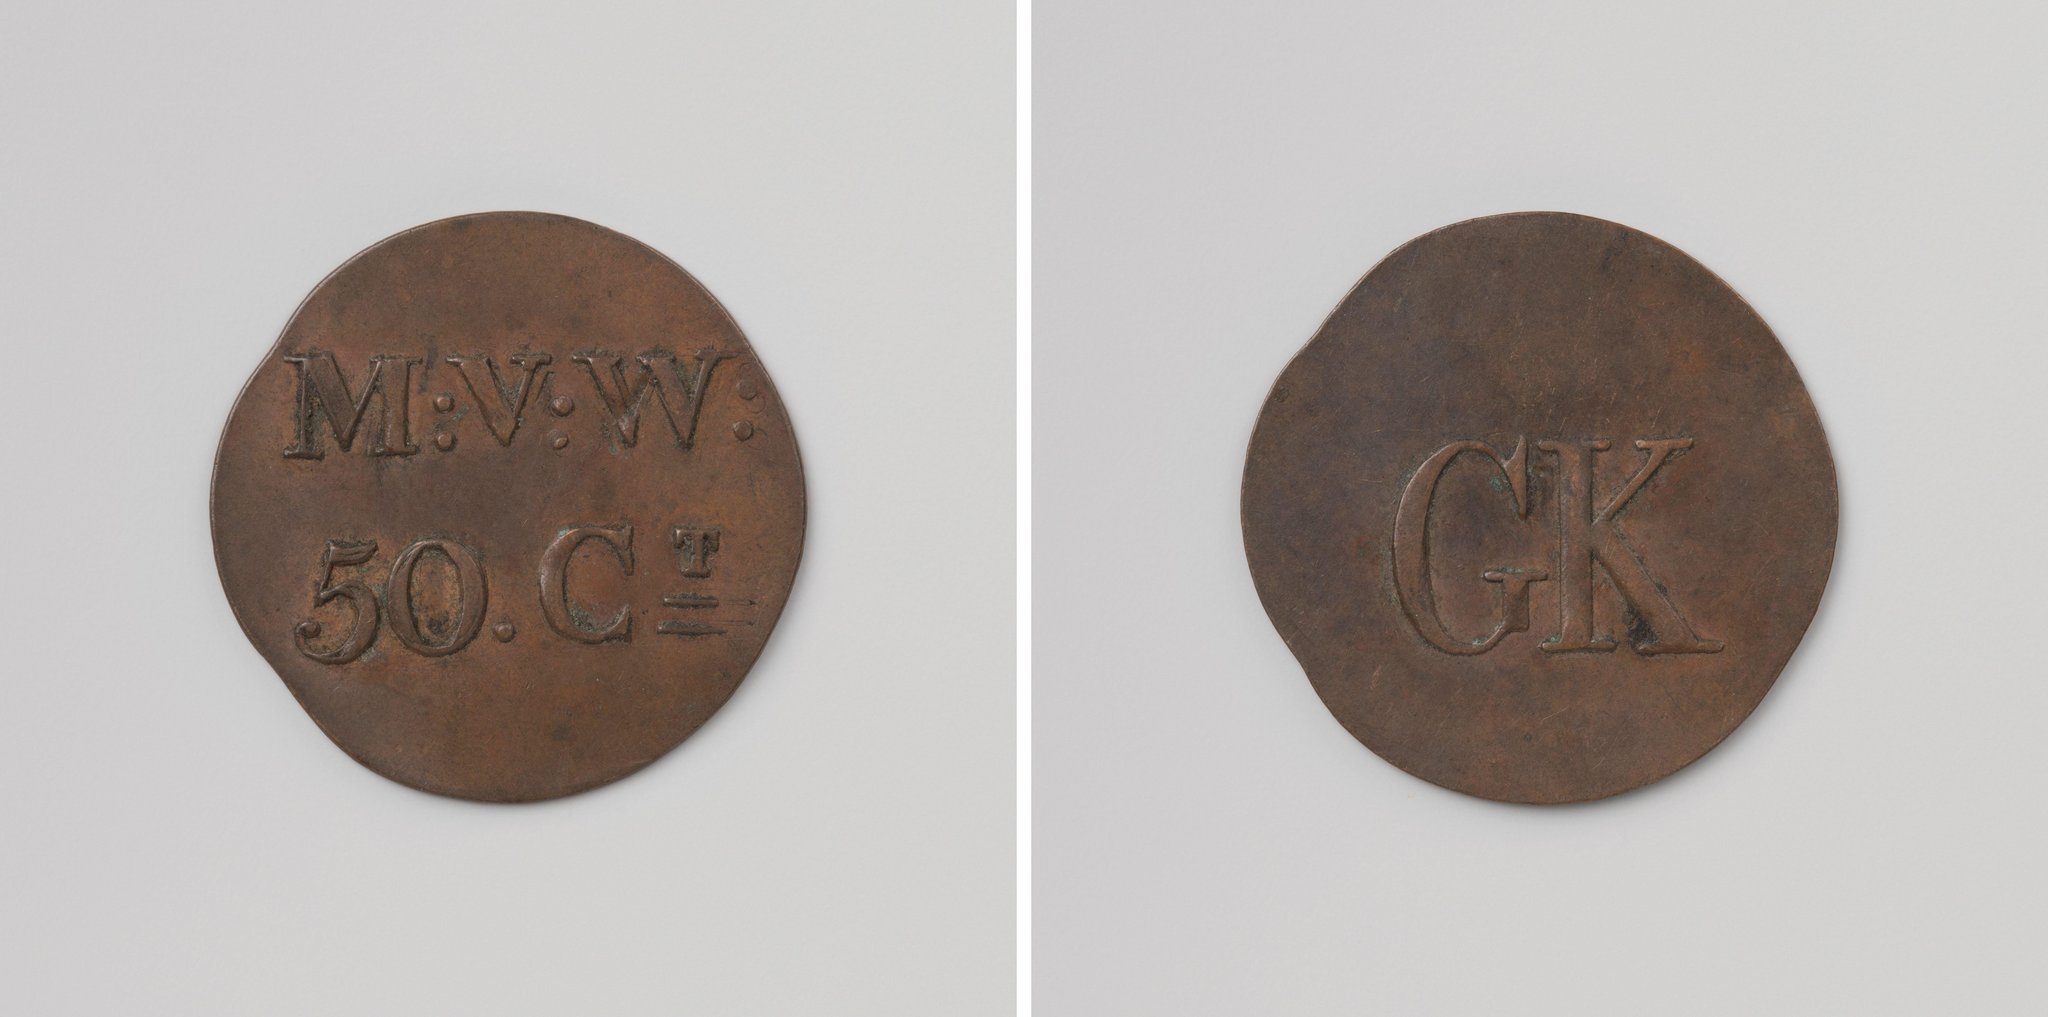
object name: monetary token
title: Huismunt geslagen op last van de Maatschappij van Weldadigheid ter waarde van 50 cent, ten behoeve van de Gewone Koloniën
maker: Anonymous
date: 1818-1859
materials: copper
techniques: striking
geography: netherlands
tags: maatschappij van weldadigheid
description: Voorzijde: opschrift boven waardeaanduiding. Keerzijde: opschrift G en K